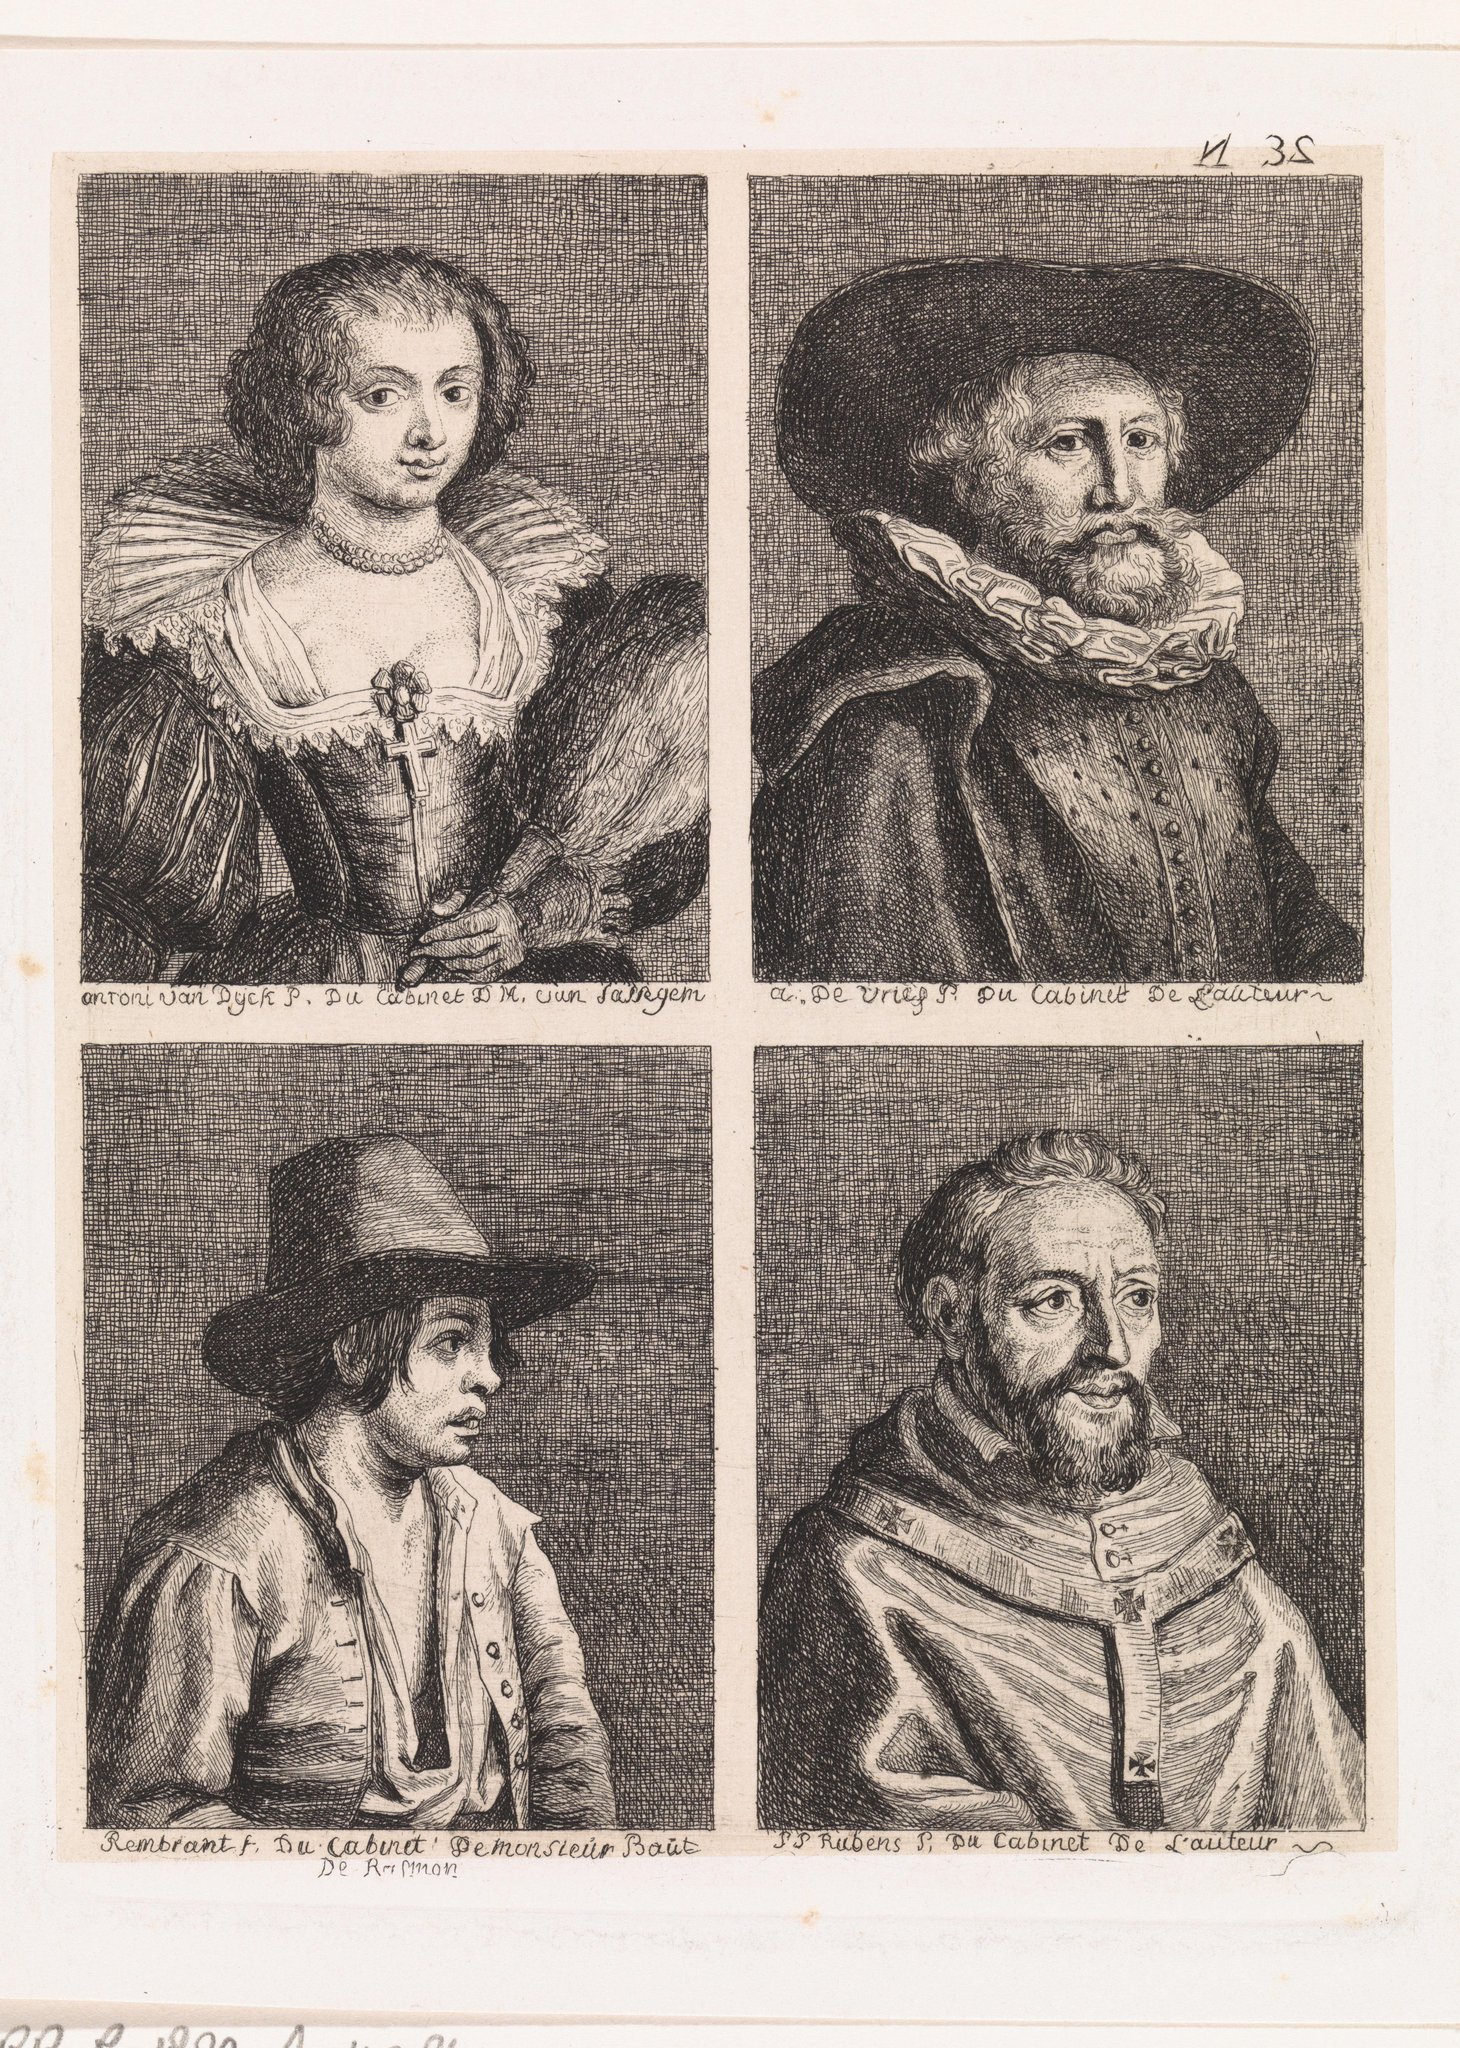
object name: print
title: Vier portretten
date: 1747-1801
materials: paper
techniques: etching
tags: adult woman, adult man, organization, functionaries and dignitaries in roman catholic church; clergy in general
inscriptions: collector's mark: Lugt 2228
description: Vier portretten. Linksboven het portret van een vrouw met waaierkraag, een kruis op de borst en een pluim in haar hand. Rechtsboven het portret van een man een plooikraag en met hoed op het hoofd. Linksonder het portret van een marskramer. Rechtsonder het portret van een geestelijke. Rechtsboven genummerd in spiegelbeeld: N. 32.